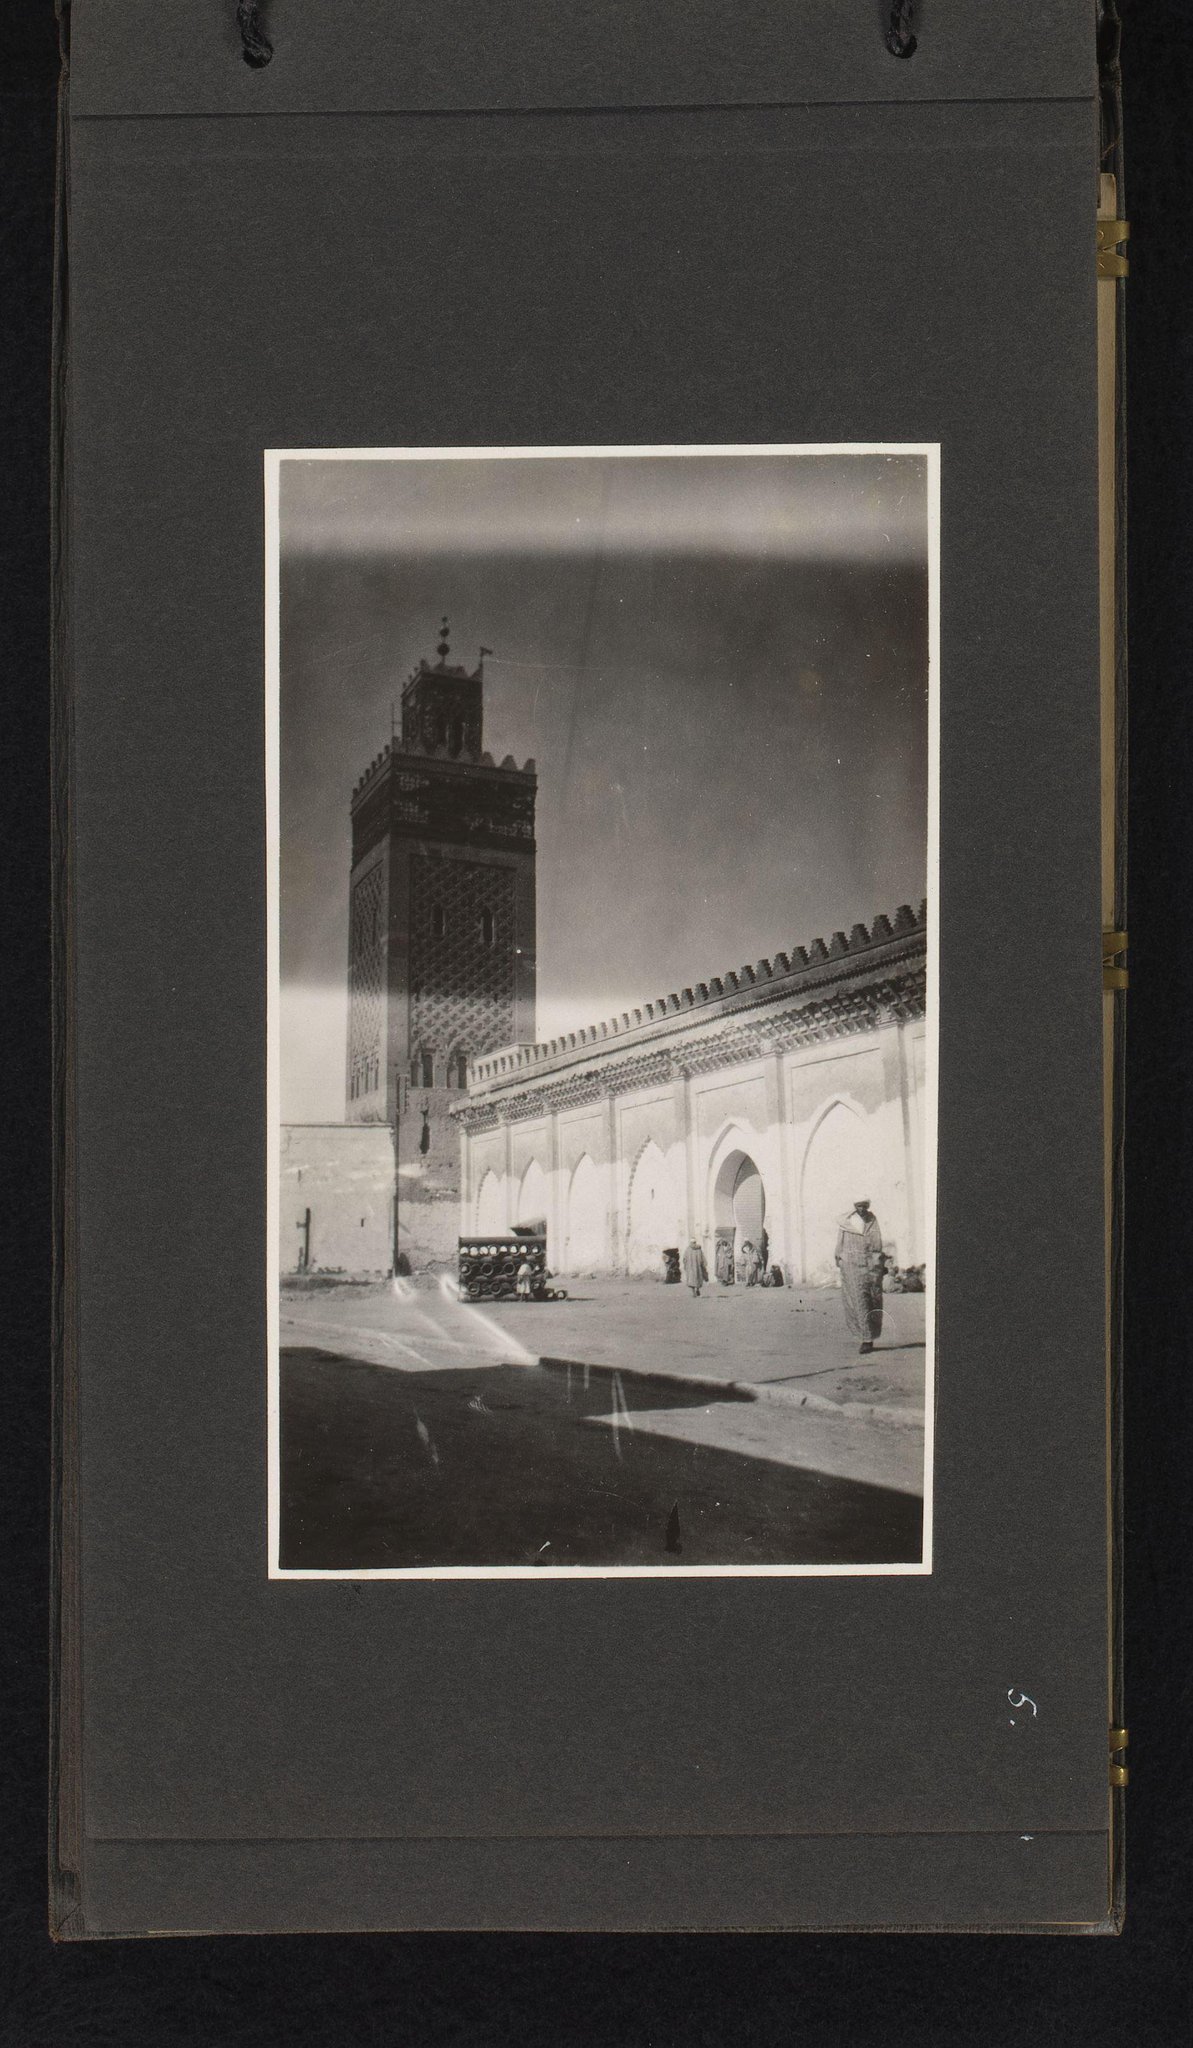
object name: photograph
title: Moskee der Kasba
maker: a.g.a. van eelde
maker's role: engineer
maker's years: 1862-1950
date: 1927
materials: paper, photographic support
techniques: gelatin silver print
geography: marrakech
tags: temple, shrine ~ islam, mohammedanism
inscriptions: number: ‘5.’